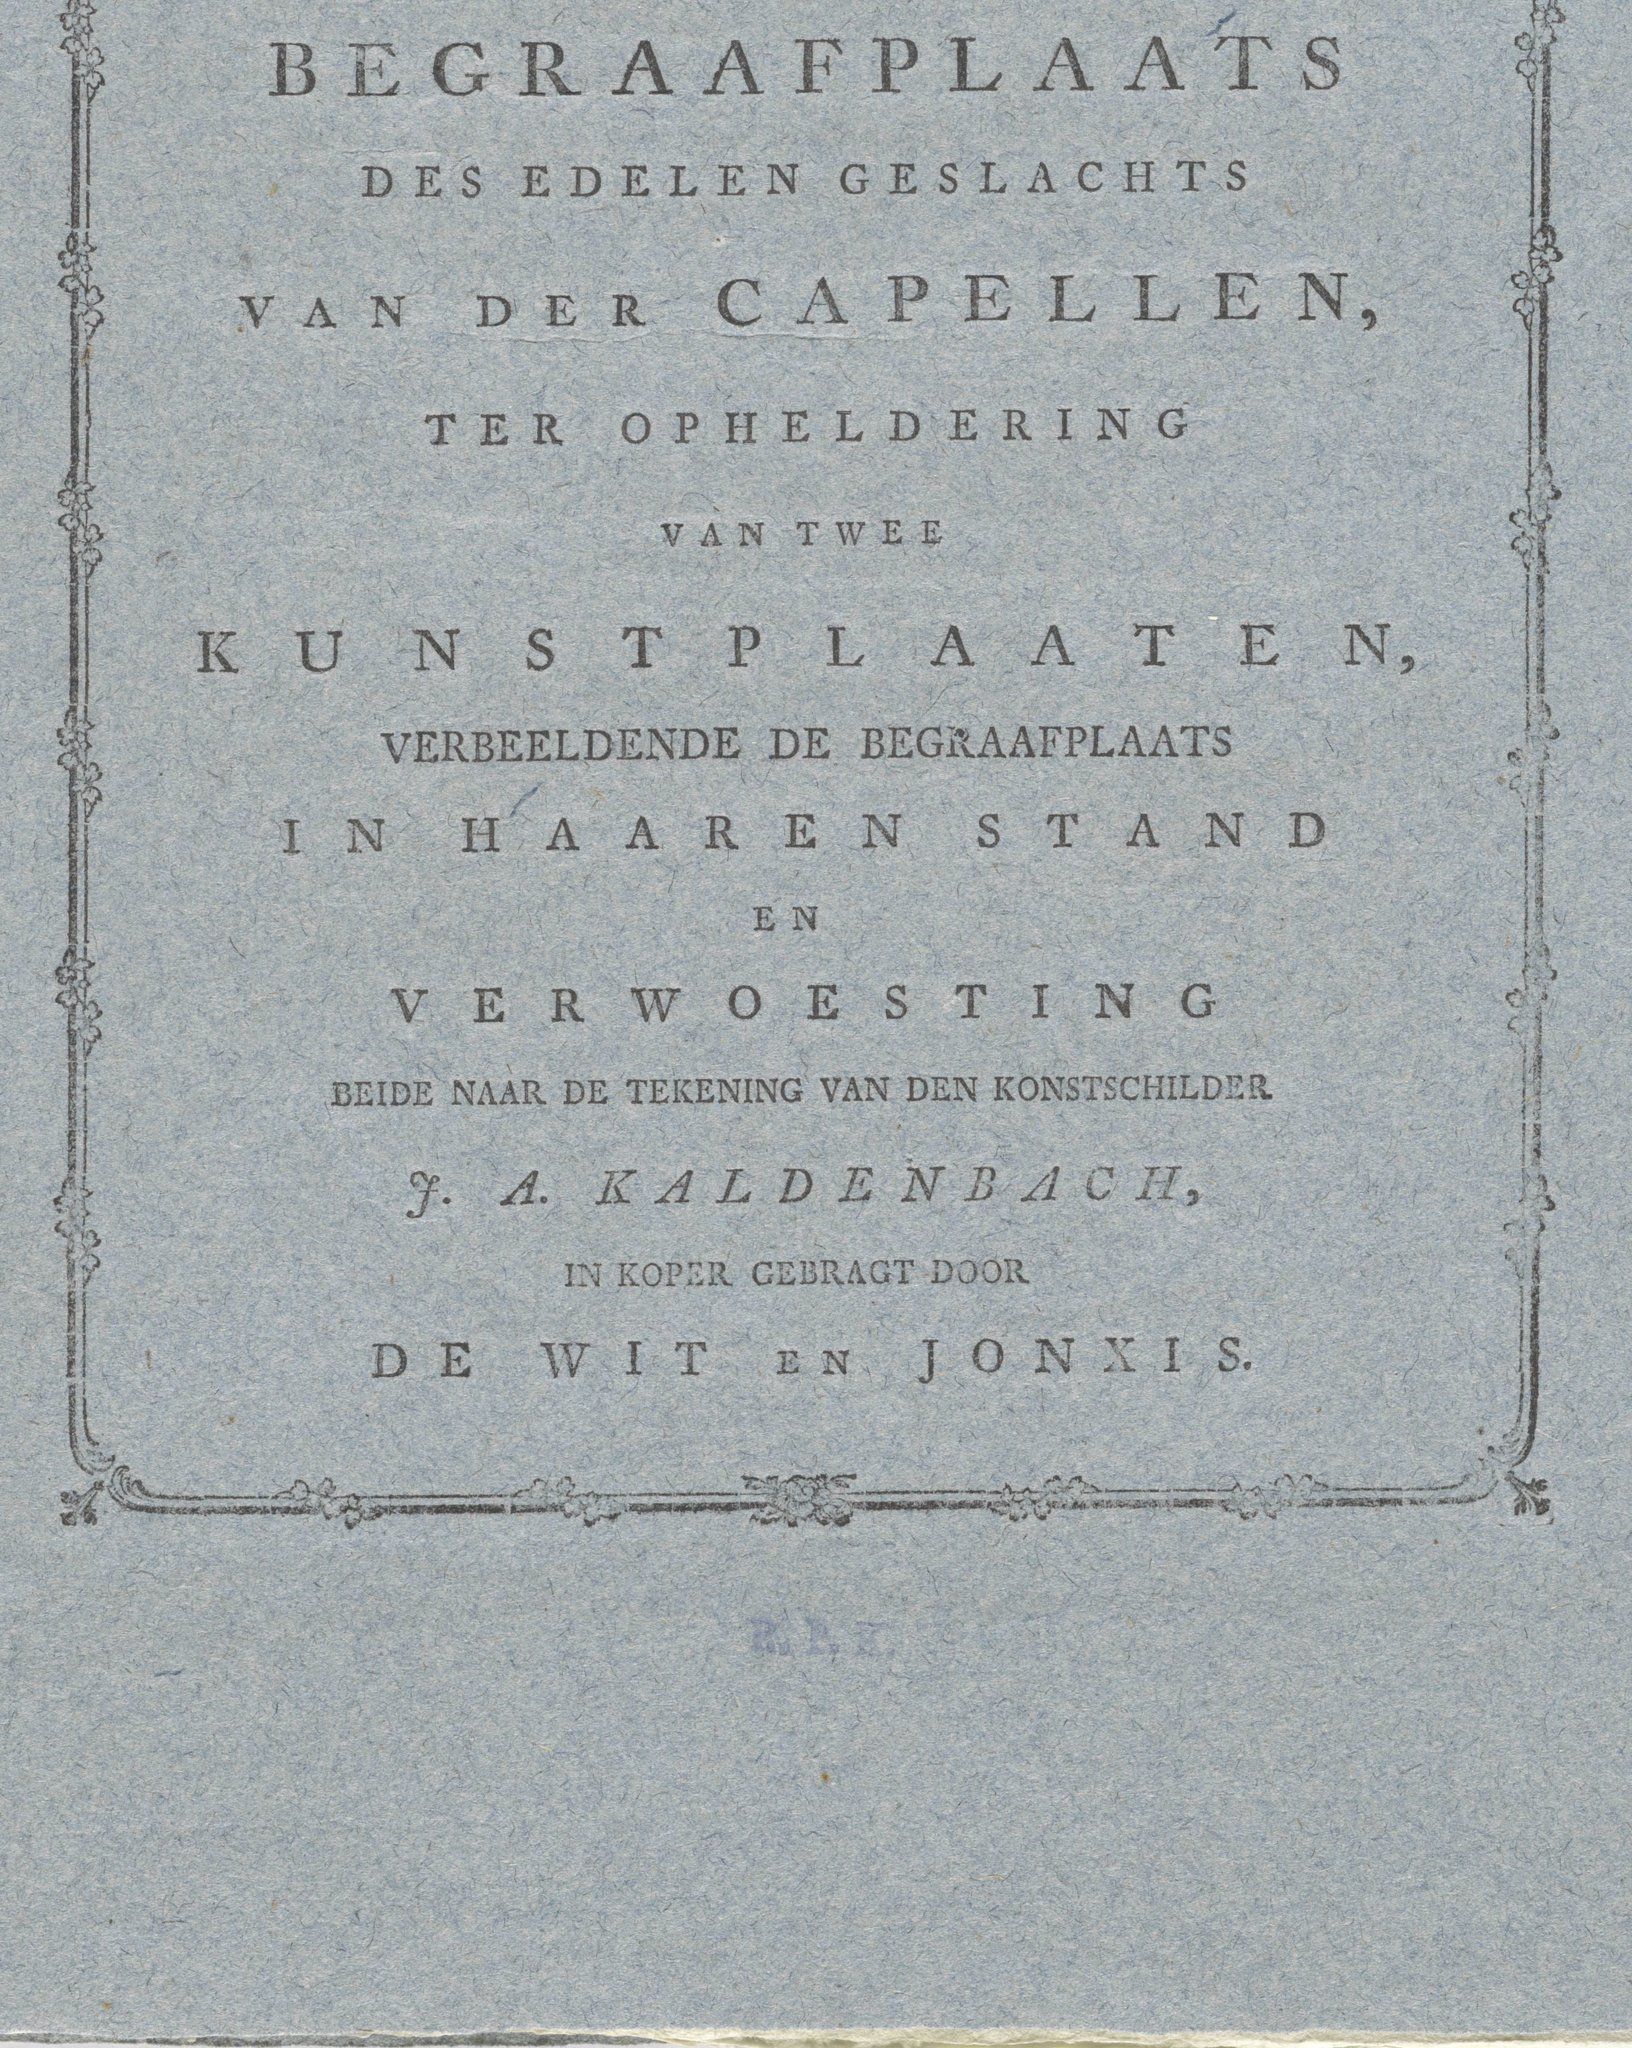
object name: book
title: Boek behorende bij twee prenten met afbeeldingen van de begraafplaats van de familie van der Capellen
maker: anthony mens jansz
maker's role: publisher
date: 1789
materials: paper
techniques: letterpress printing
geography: amsterdam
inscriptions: collector's mark: Lugt 2228